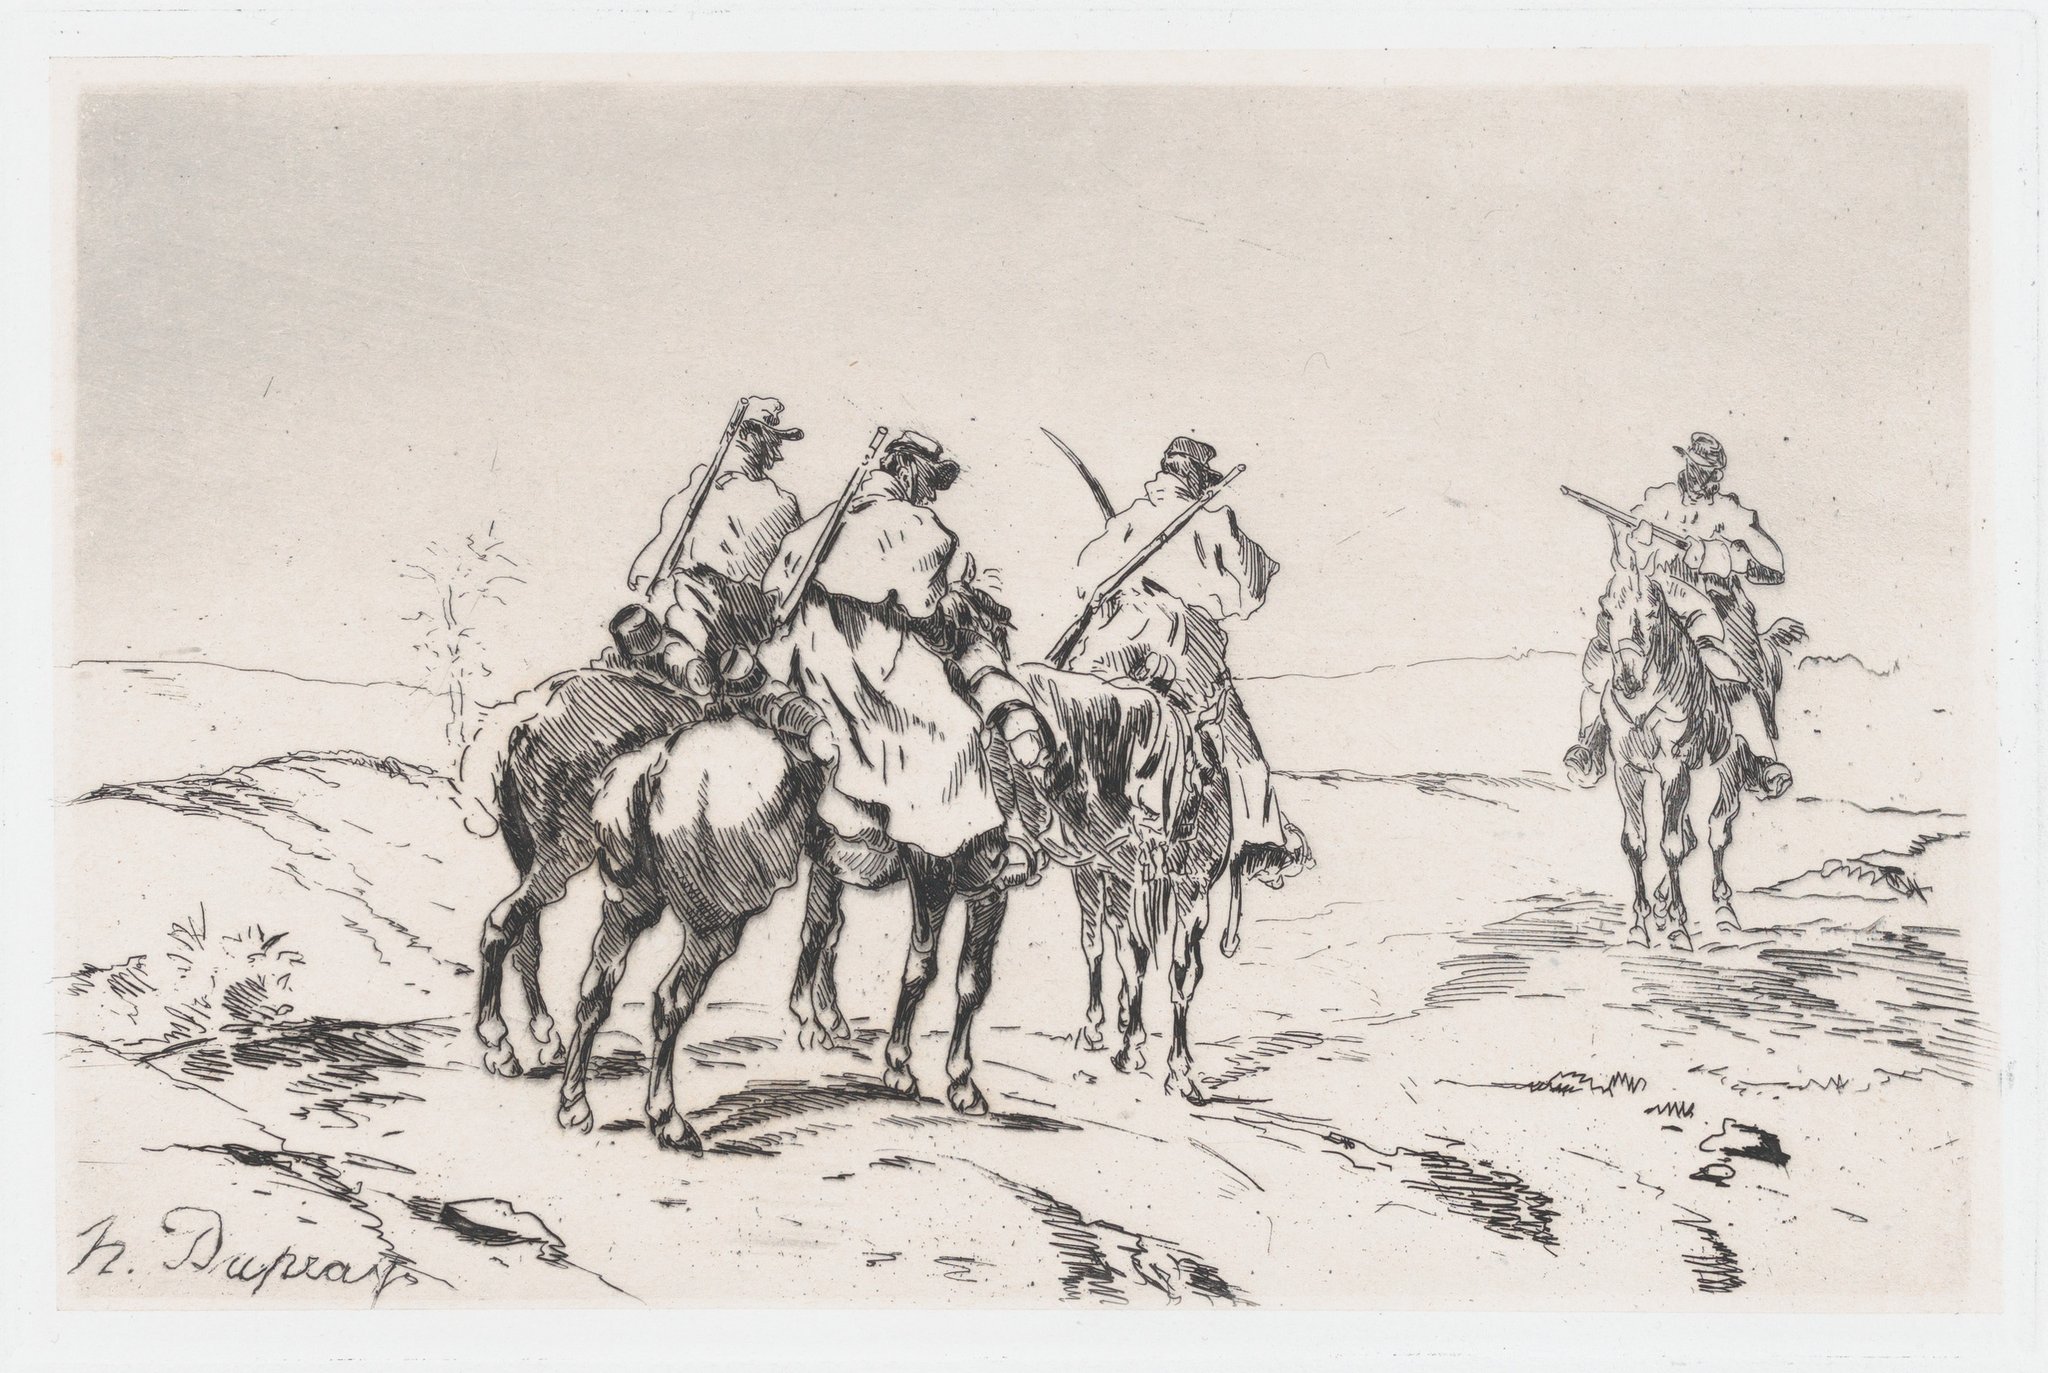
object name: print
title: The Patrol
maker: henri-louis dupray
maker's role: etcher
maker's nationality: french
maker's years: 1841-1909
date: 1875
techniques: printmaking, etching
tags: soldiers,men,horses